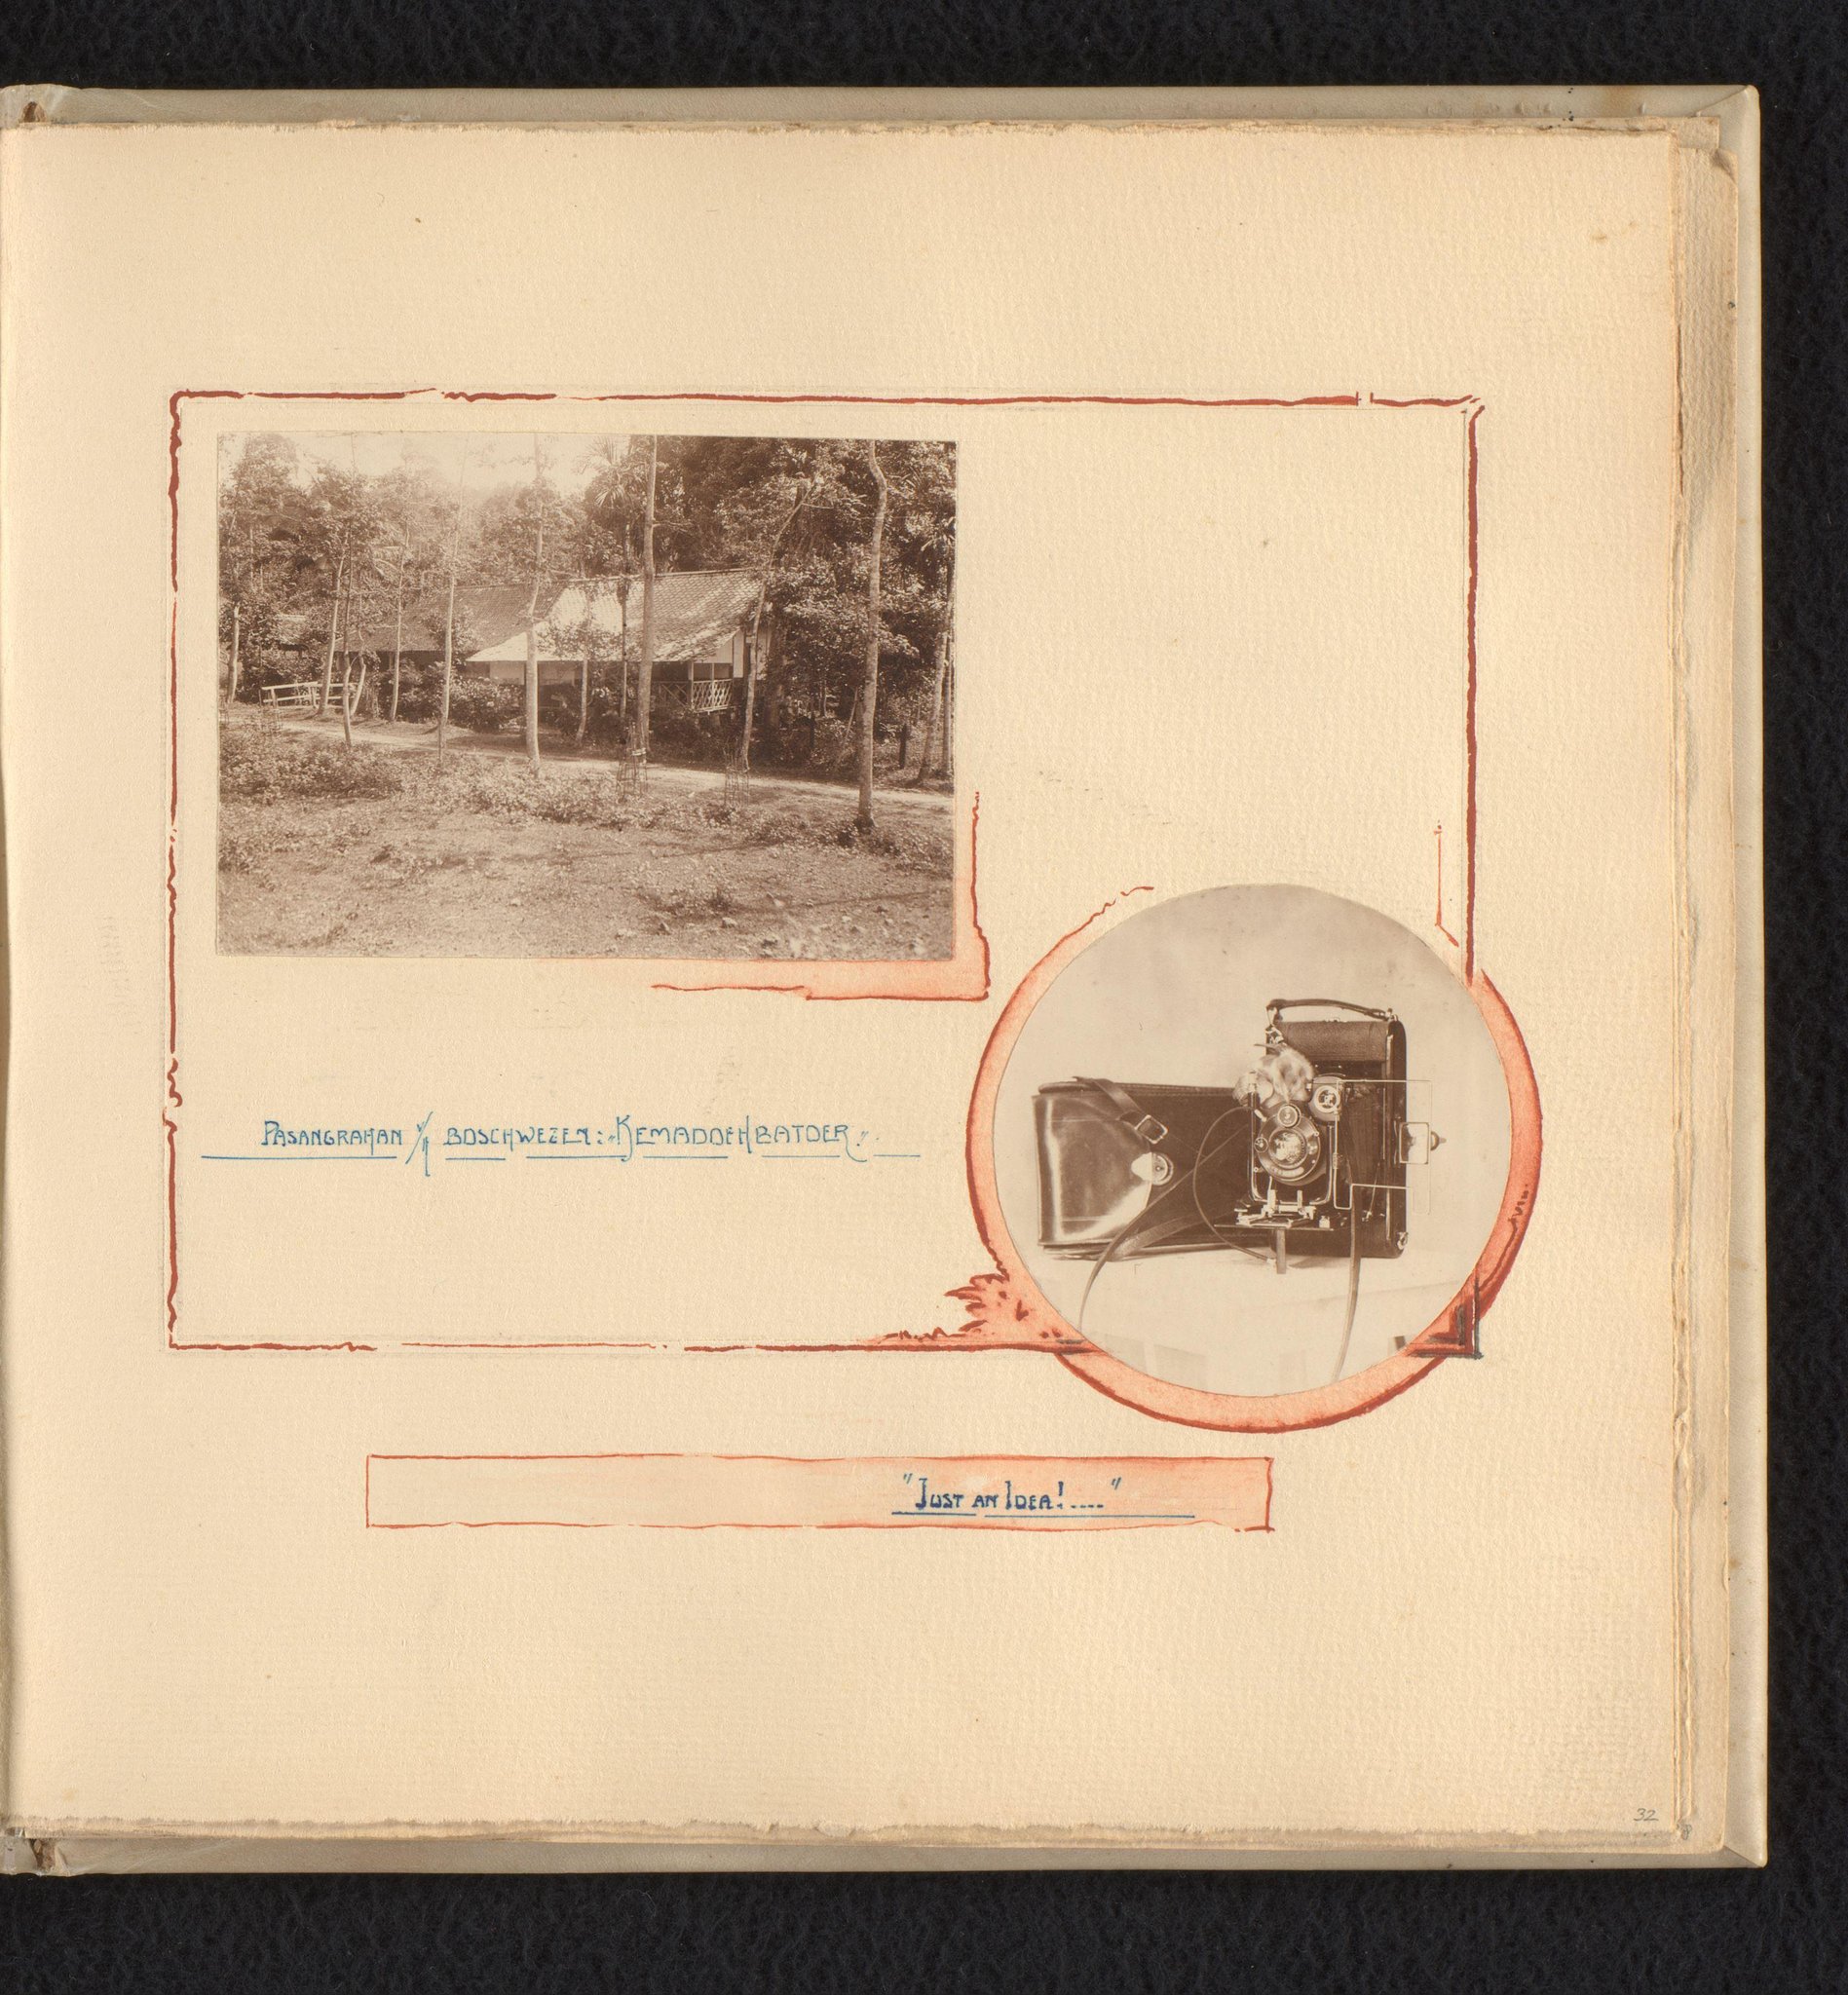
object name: photograph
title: Pasangrahan in Grobogan en een fototoestel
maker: Anonymous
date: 1910-1928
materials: paper, photographic support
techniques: drawing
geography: grobogan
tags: camera ~ photography, jungle, colonial government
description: Albumblad met twee foto's van de pasangrahan van het Boschwezen in Grobogan en van een fototoestel. Het blad is versierd met randwerk om de foto's. Onderdeel van het fotoalbum aangeboden aan J. Habbema door het Binnenlandsch Bestuur Corps van het Regentschap Grobogan, bij het beëindigen van zijn bestuur over het Regentschap, waarschijnlijk in 1928.